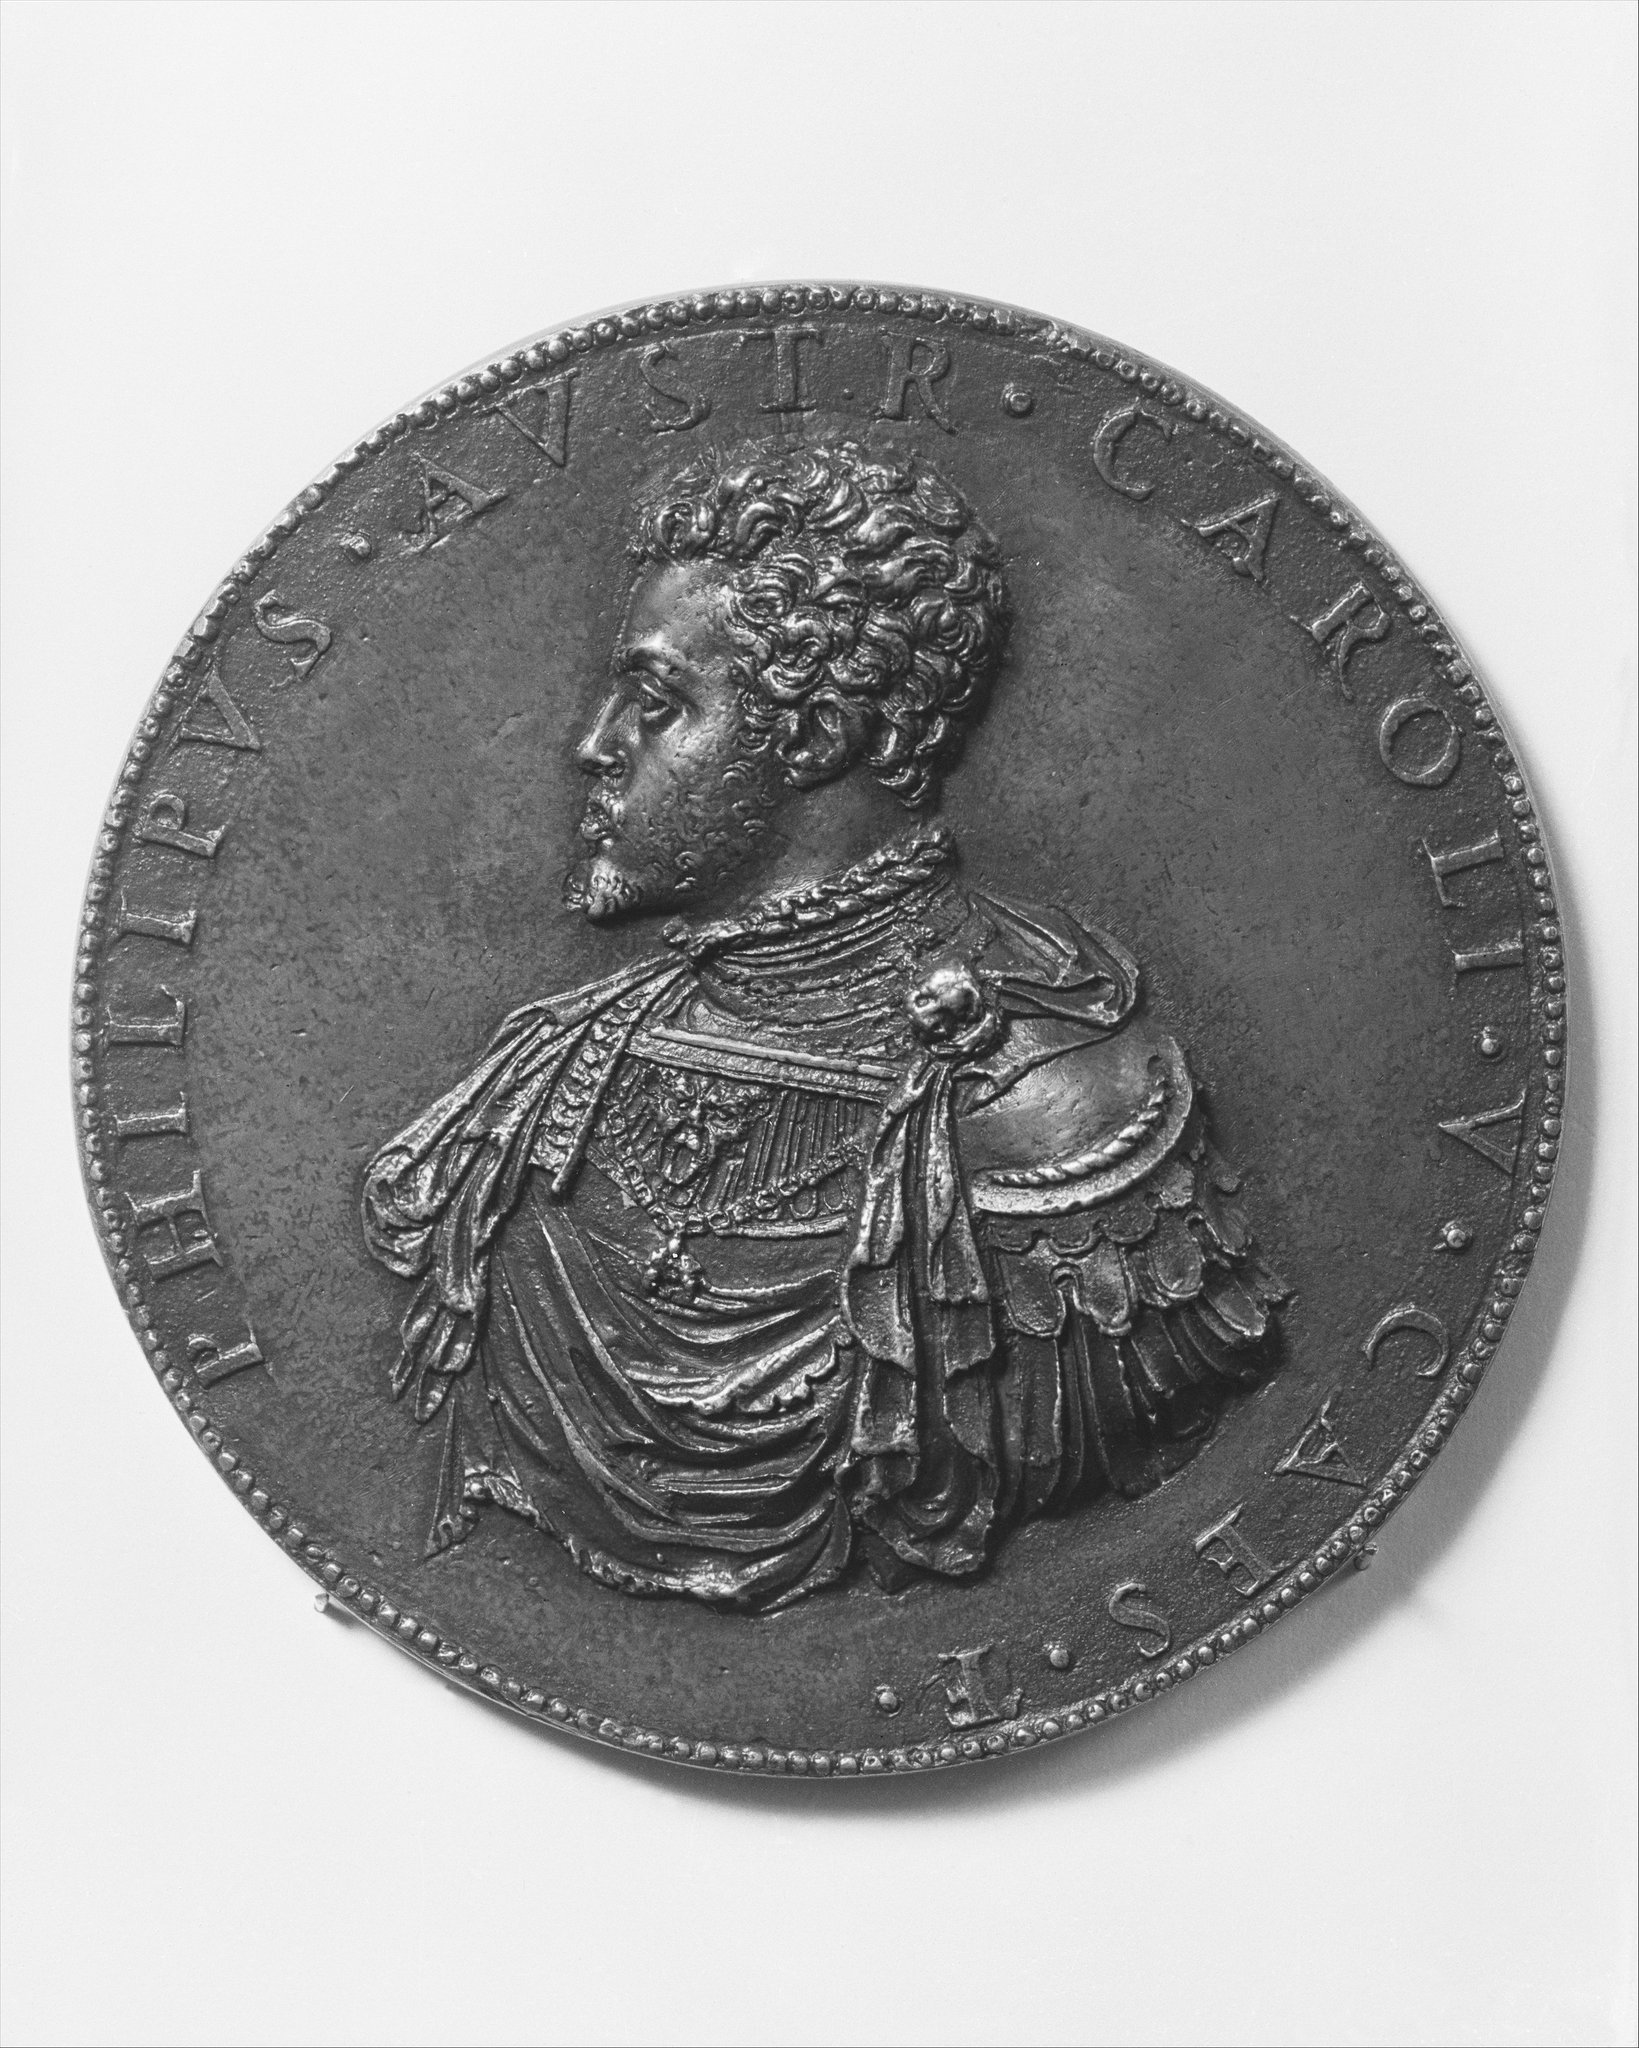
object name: medal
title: The Infante Philip of Spain, later Philip II of Spain (1527–98, r. 1556)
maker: leone leoni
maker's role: artist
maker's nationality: italian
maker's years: 1504-1590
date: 1549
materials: bronze, patina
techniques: casting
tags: men,profiles